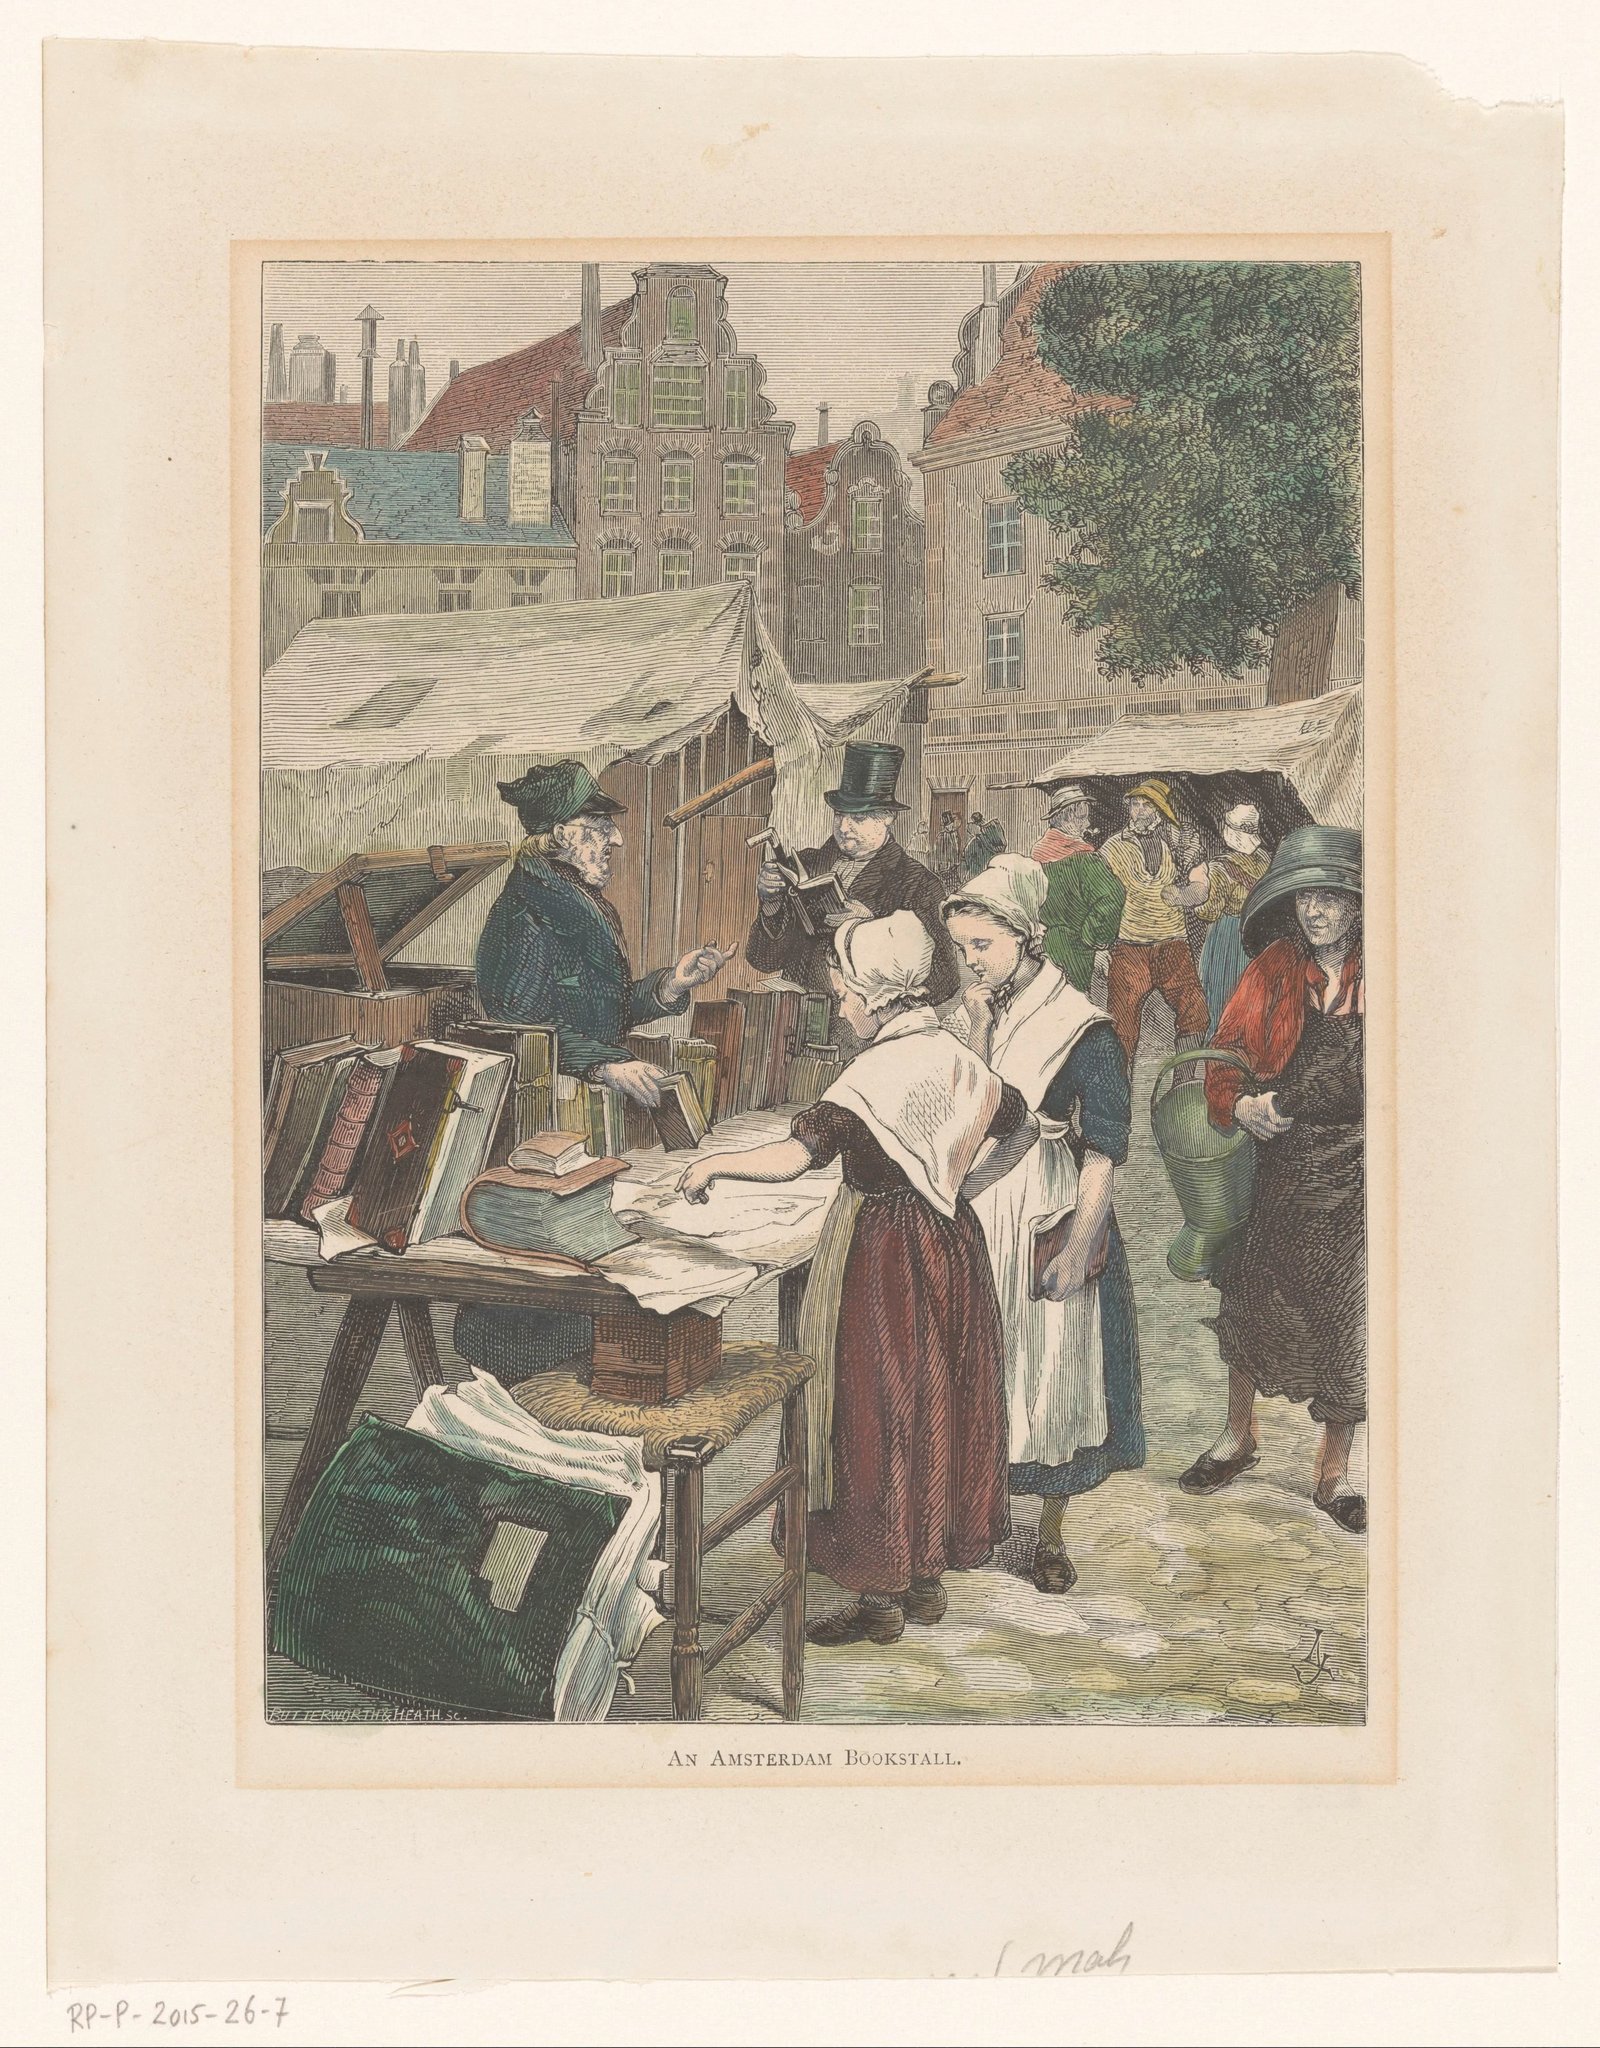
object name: print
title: An Amsterdam bookstall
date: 1887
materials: paper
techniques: hand coloring, engraving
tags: book-stall, kiosk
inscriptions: collector's mark: Lugt 2228, collector's mark: Lugt 4780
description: Twee weesmeisjes en een man met een hoge hoed bekijken het aanbod van een boekverkoper. Waarschijnlijk de Botermarkt in Amsterdam.